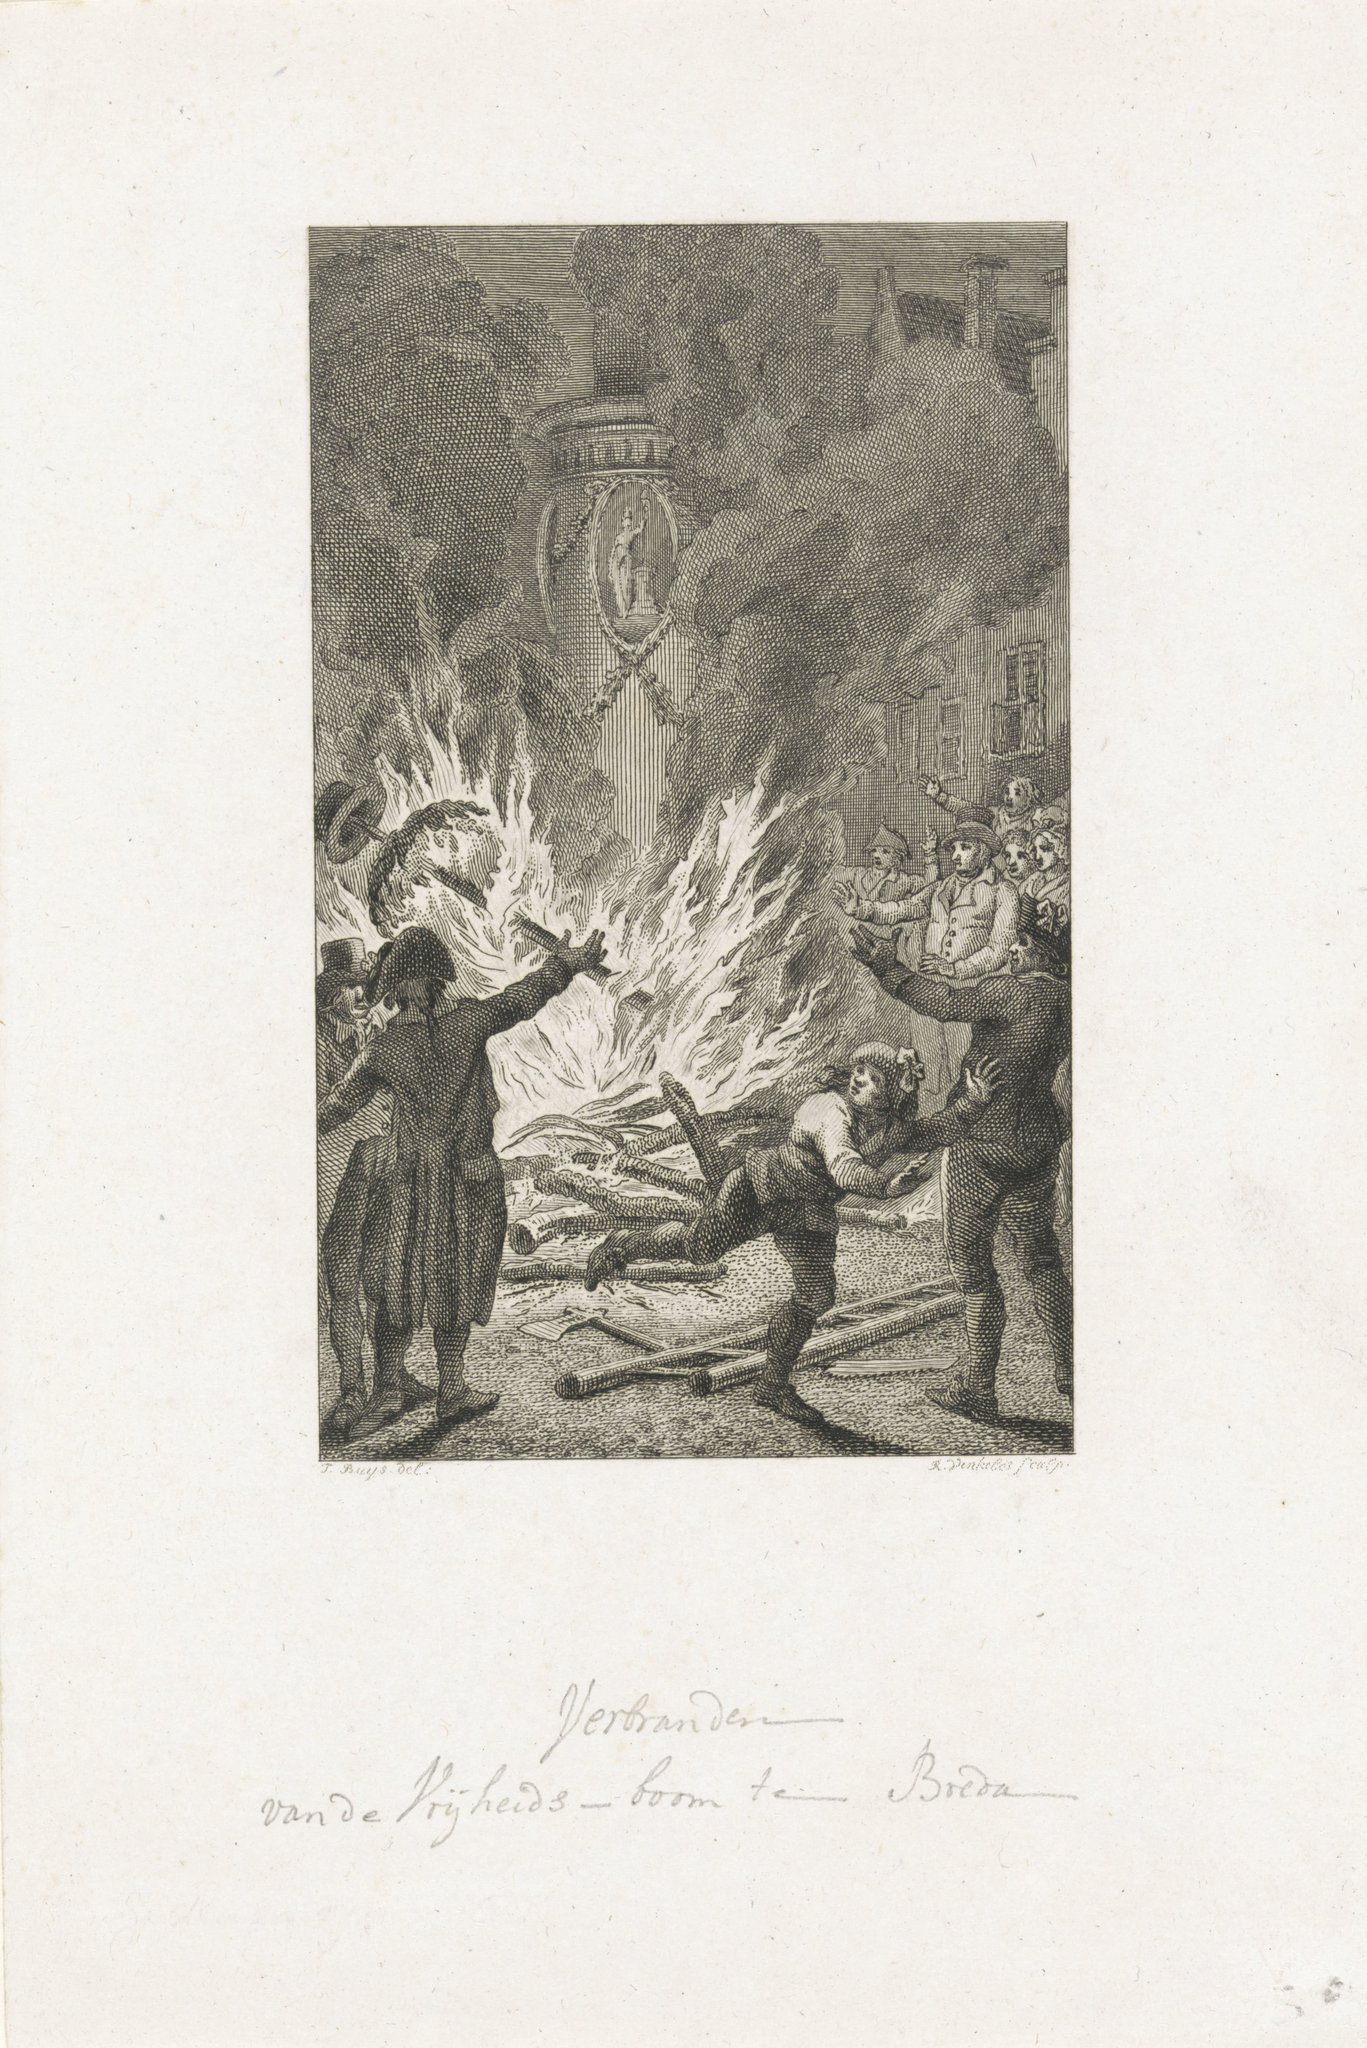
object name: history print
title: Verbranden van de Vrijheidsboom te Breda 1793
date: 1801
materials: paper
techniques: engraving, etching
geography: northern netherlands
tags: on fire, ablaze, dancing around the tree of liberty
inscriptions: collector's mark: Lugt 240, collector's mark: Lugt 2228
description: Gebruikt als illustratie in: P.A. Loosjes. Vaderlandsche historie, vervattende de geschiedenissen, der Vereenigde Nederlanden (...). Ten onmiddelyken vervolge van Wagenaar's Vaderlandsche historie. Amsterdam: Johannes Allart, dl. 26 (1801).